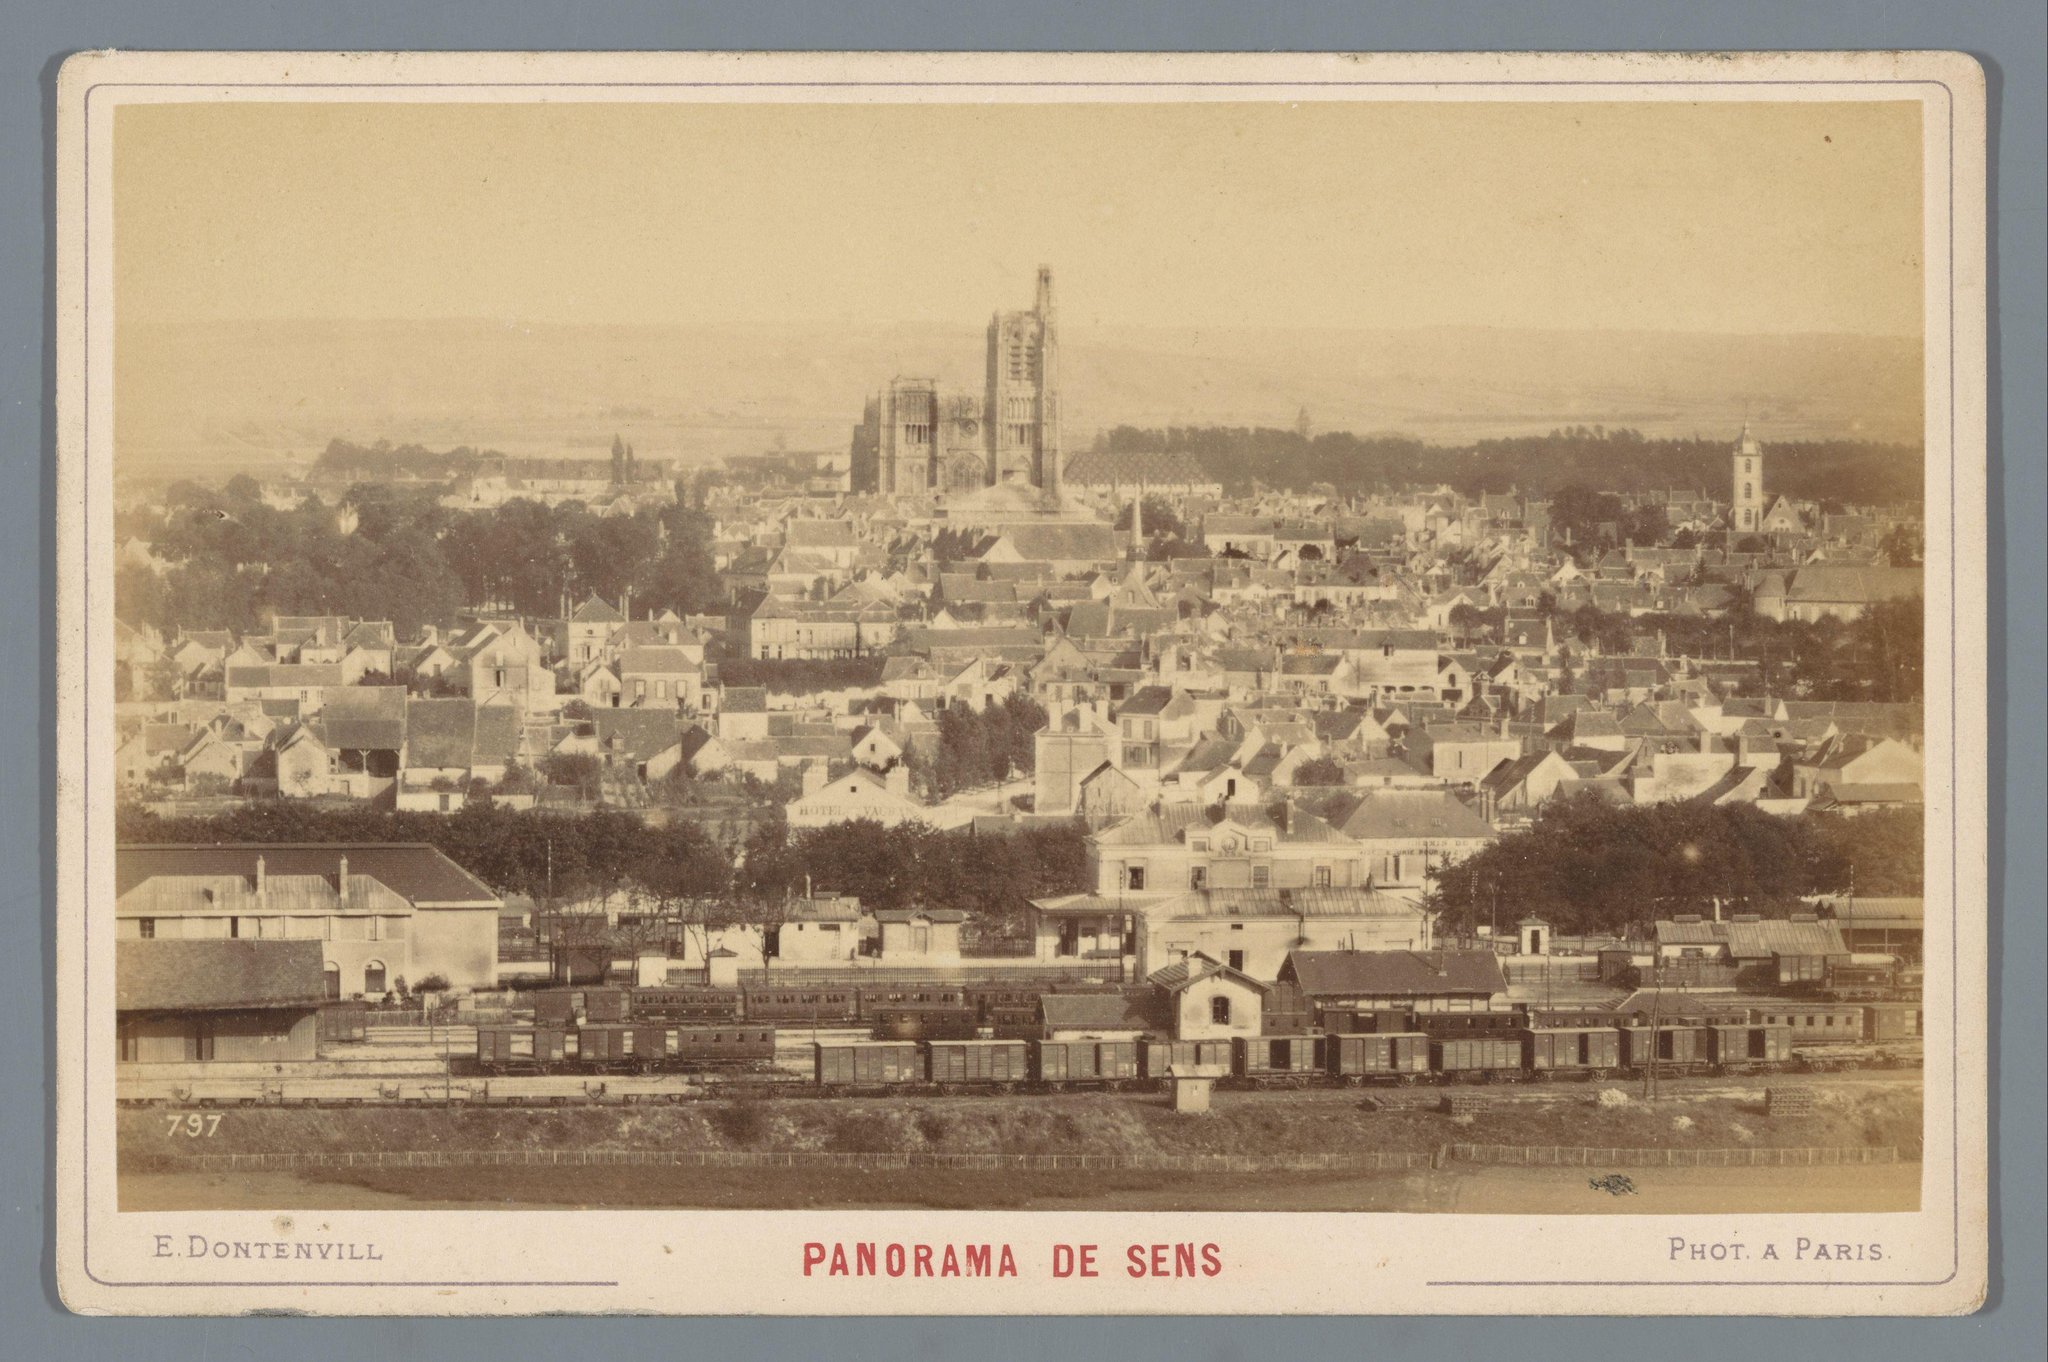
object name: photograph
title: Gezicht op Sens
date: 1893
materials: cardboard, photographic support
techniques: albumen print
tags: city-view in general; 'veduta'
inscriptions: date: ‘10 Septembre 1893 (gaston)’, inscription: ‘Phot. a Paris.’, number: ‘797’